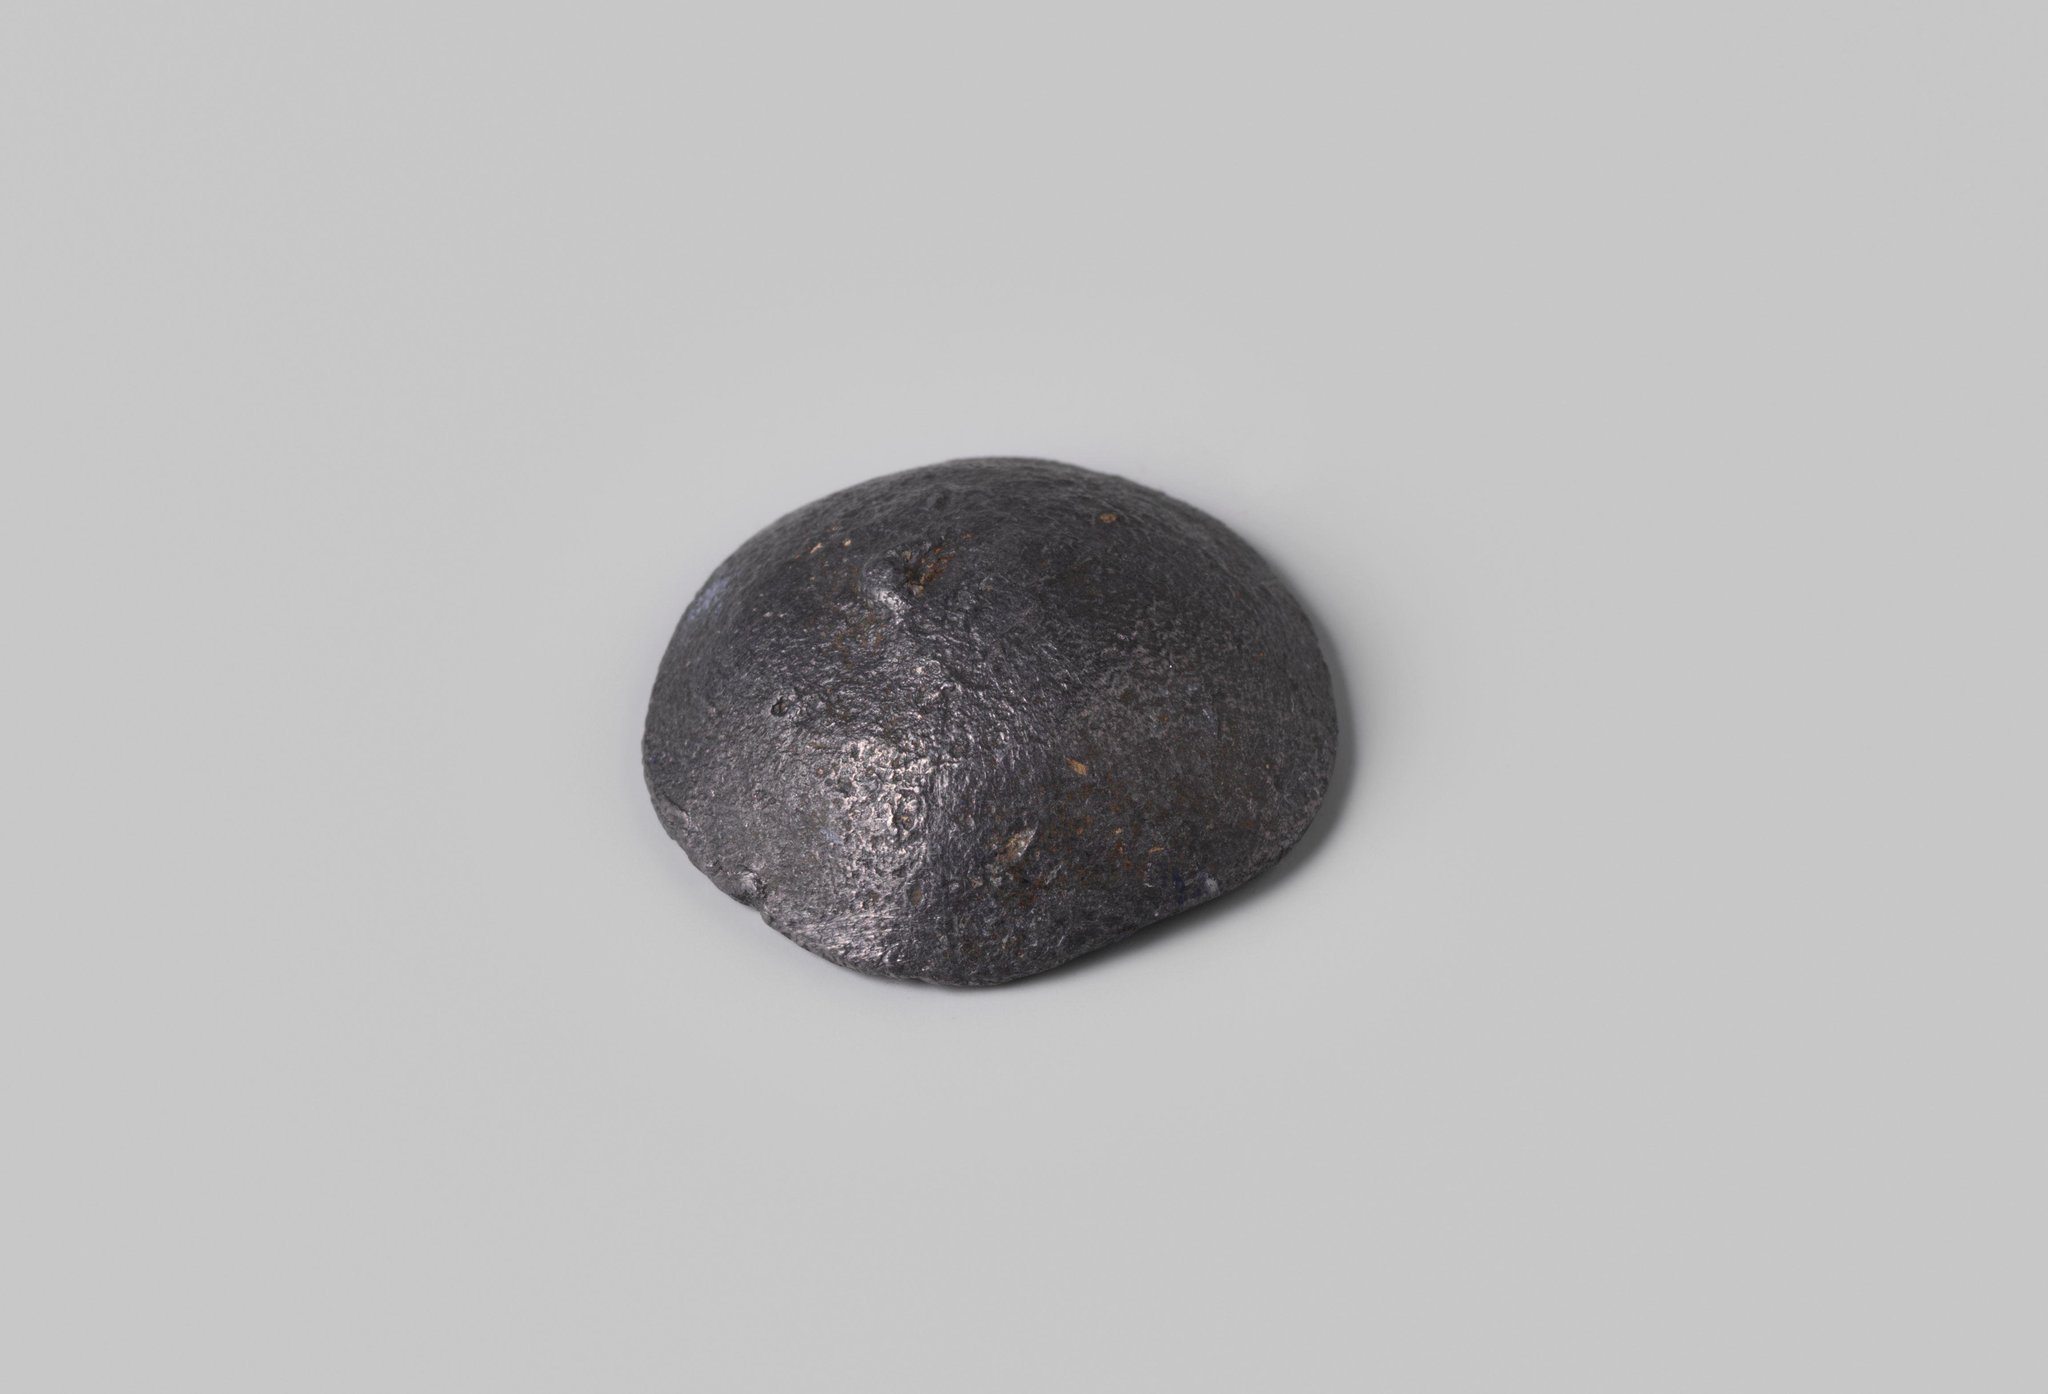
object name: weight scale component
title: Lead weight from the wreck of the Dutch East India ship Hollandia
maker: Anonymous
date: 1700-1743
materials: lead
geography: netherlands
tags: verenigde oostindische compagnie, hollandia (schip), annet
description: Disc-shaped weight, circular, domed top, flat underside.